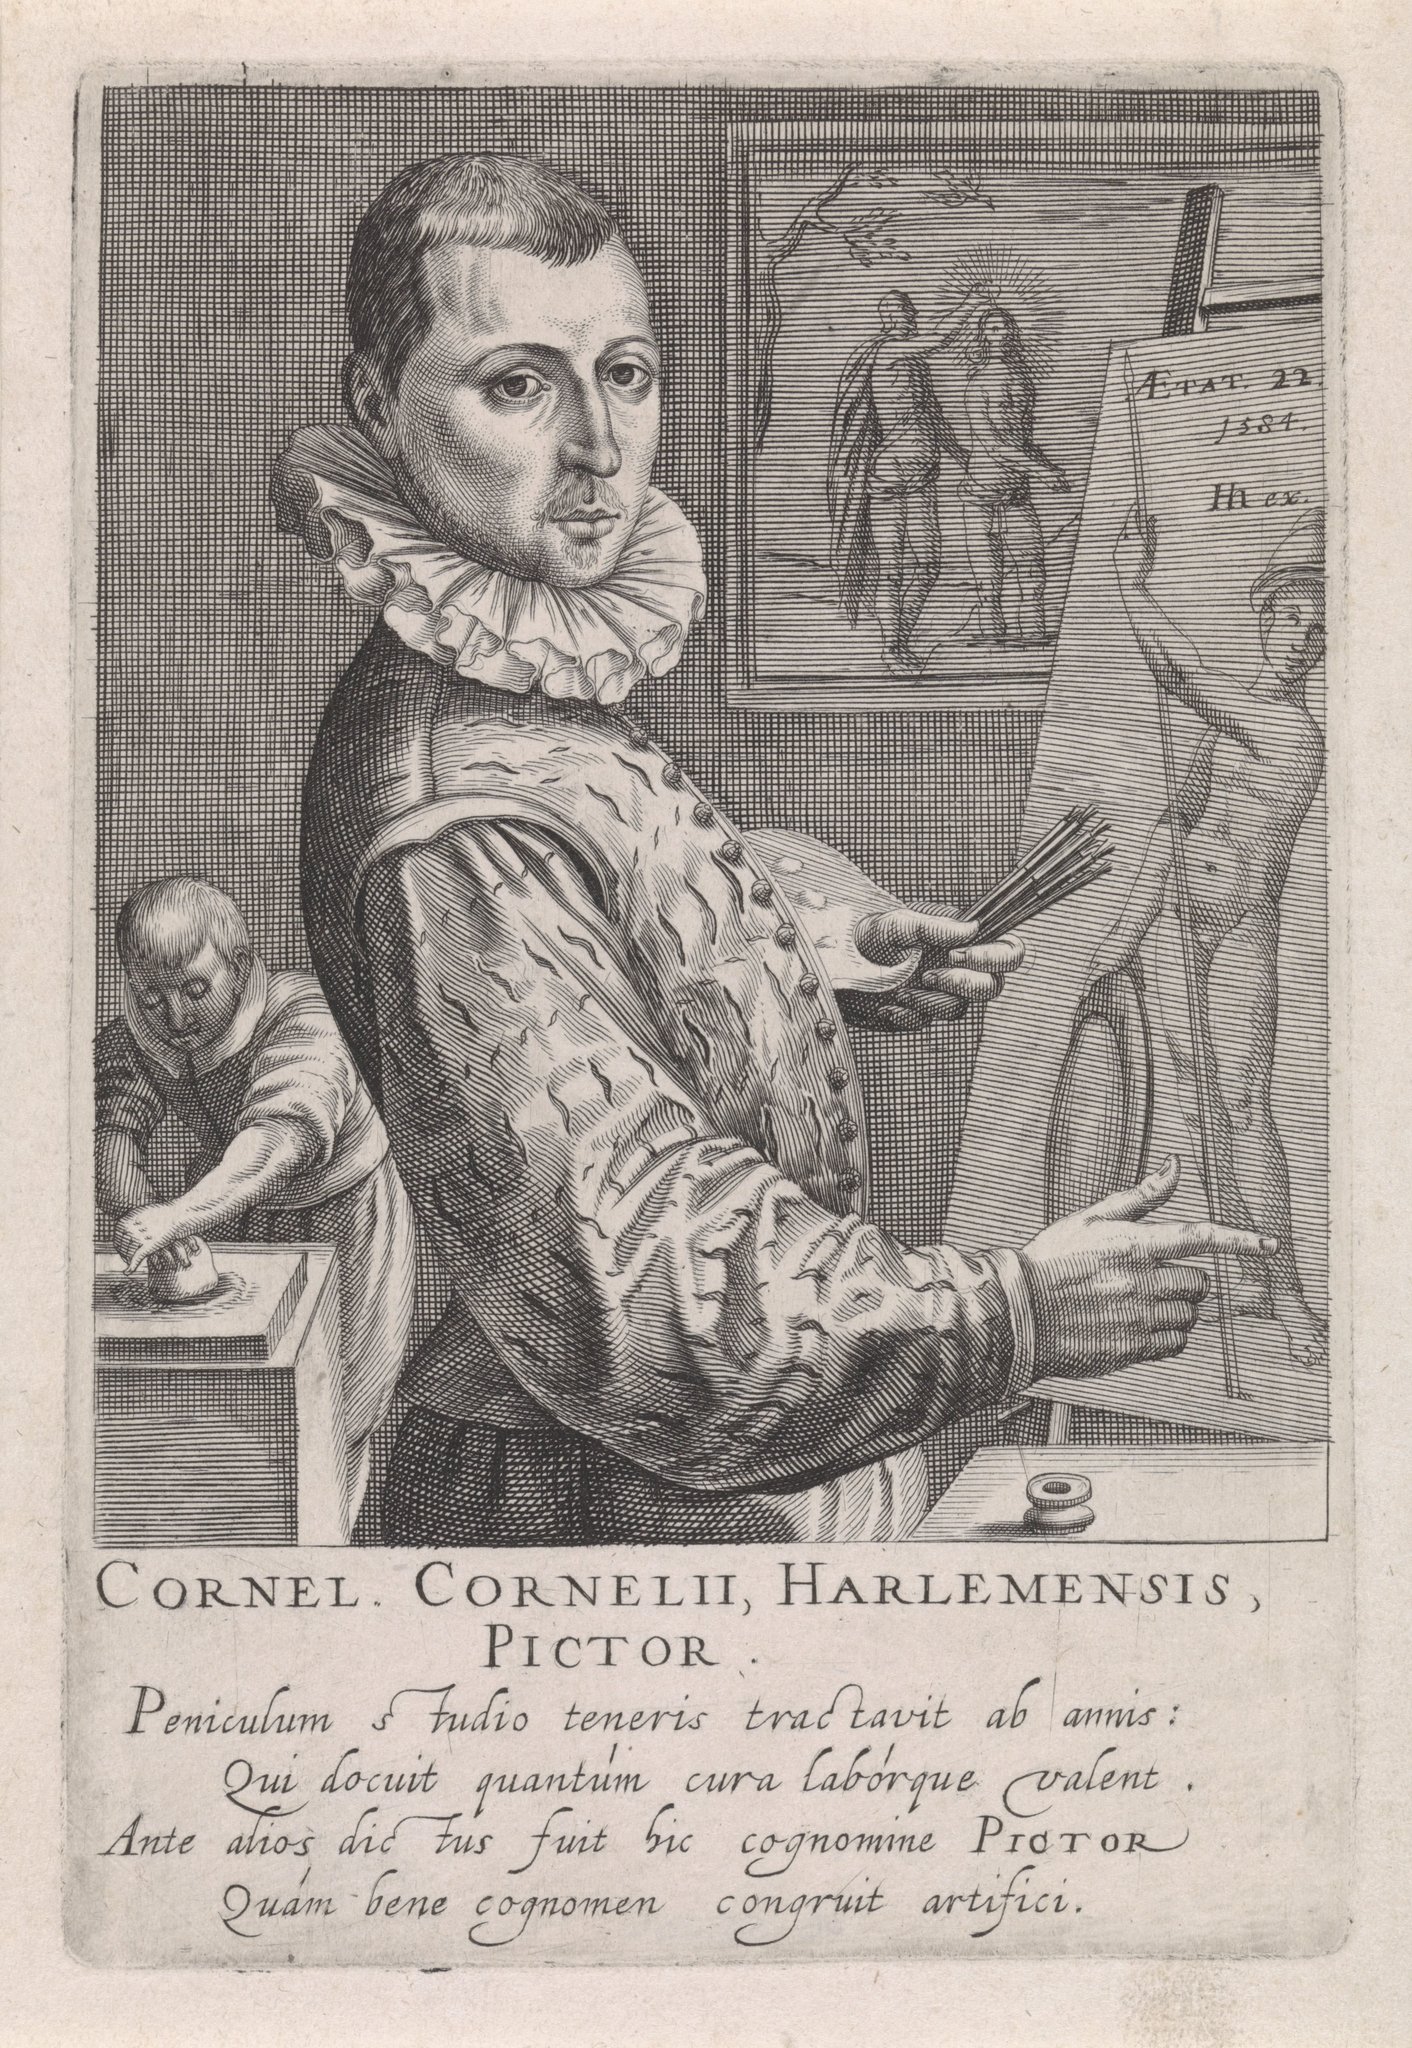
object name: print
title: Portret van Cornelis Cornelisz. van Haarlem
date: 1610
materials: paper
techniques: engraving, etching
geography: the hague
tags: haarlem, painter, draughtsman, cornelis cornelisz. van haarlem, portrait, self-portrait of painter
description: Portret ten halven lijve naar rechts van Cornelis Cornelisz. van Haarlem. Onder het portret zijn naam en vier regels in het Latijn. Prent uit deel 3 van de serie Pictorum Aliquot Celebrium Praecipuae Germaniae Inferioris Effigies. Serie van 72 kunstenaarsportretten vervaardigd door Hendrick Hondius I, Simon Frisius, Andries Jacobsz. Stock en Robert de Baudous.